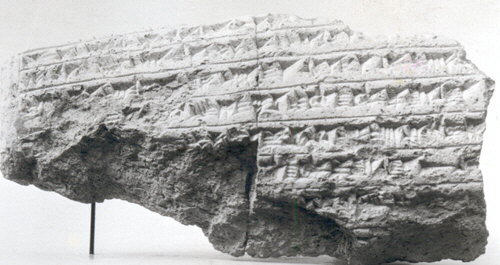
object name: cuneiform cylinder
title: Cuneiform cylinder: inscription of Ashurbanipal describing restorations of the city wall and gates at Borsippa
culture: assyrian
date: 668-627 BCE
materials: clay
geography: mesopotamia